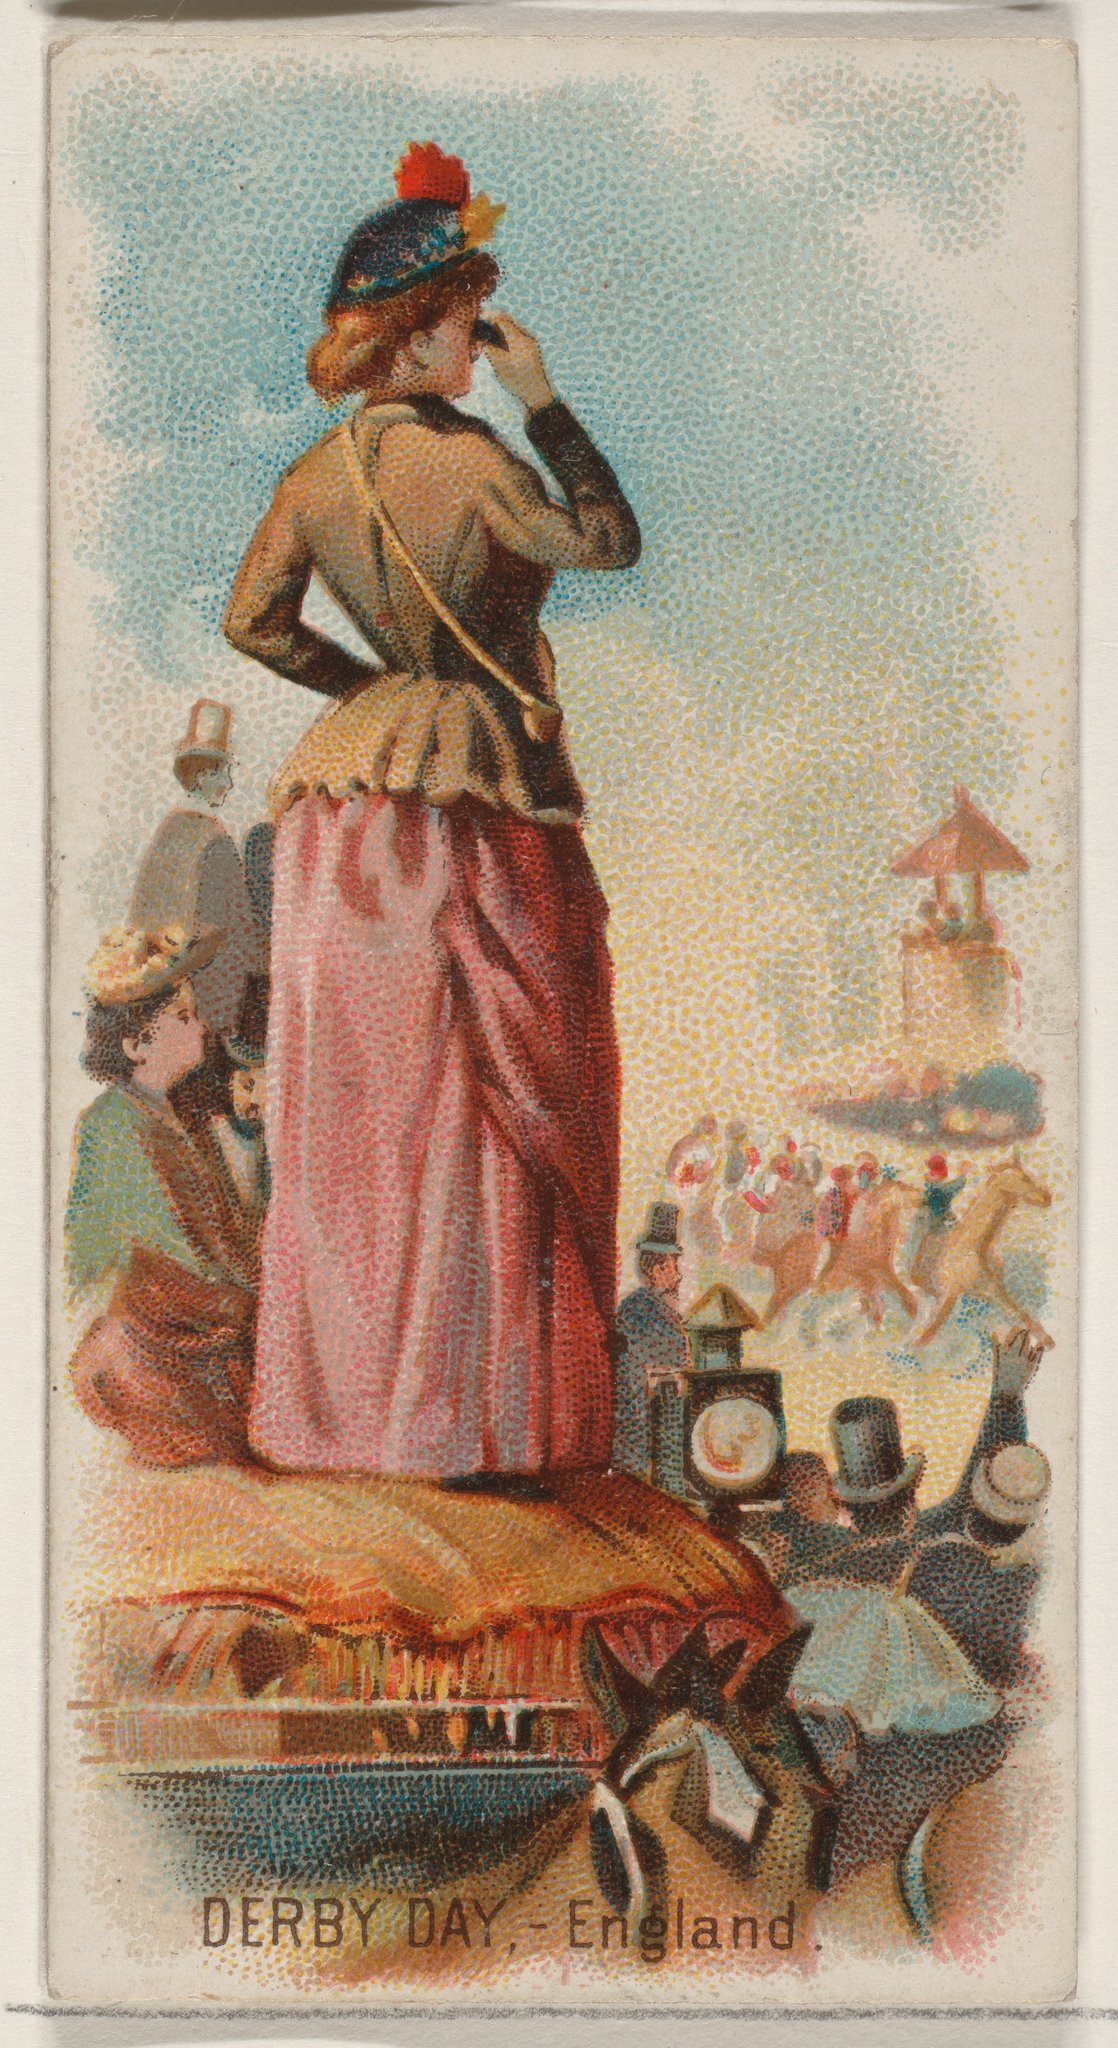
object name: print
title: Derby Day, England, from the Holidays series (N80) for Duke brand cigarettes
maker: w. duke, sons & co.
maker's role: publisher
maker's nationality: american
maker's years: 1870-1920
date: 1890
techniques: color lithograph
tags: women